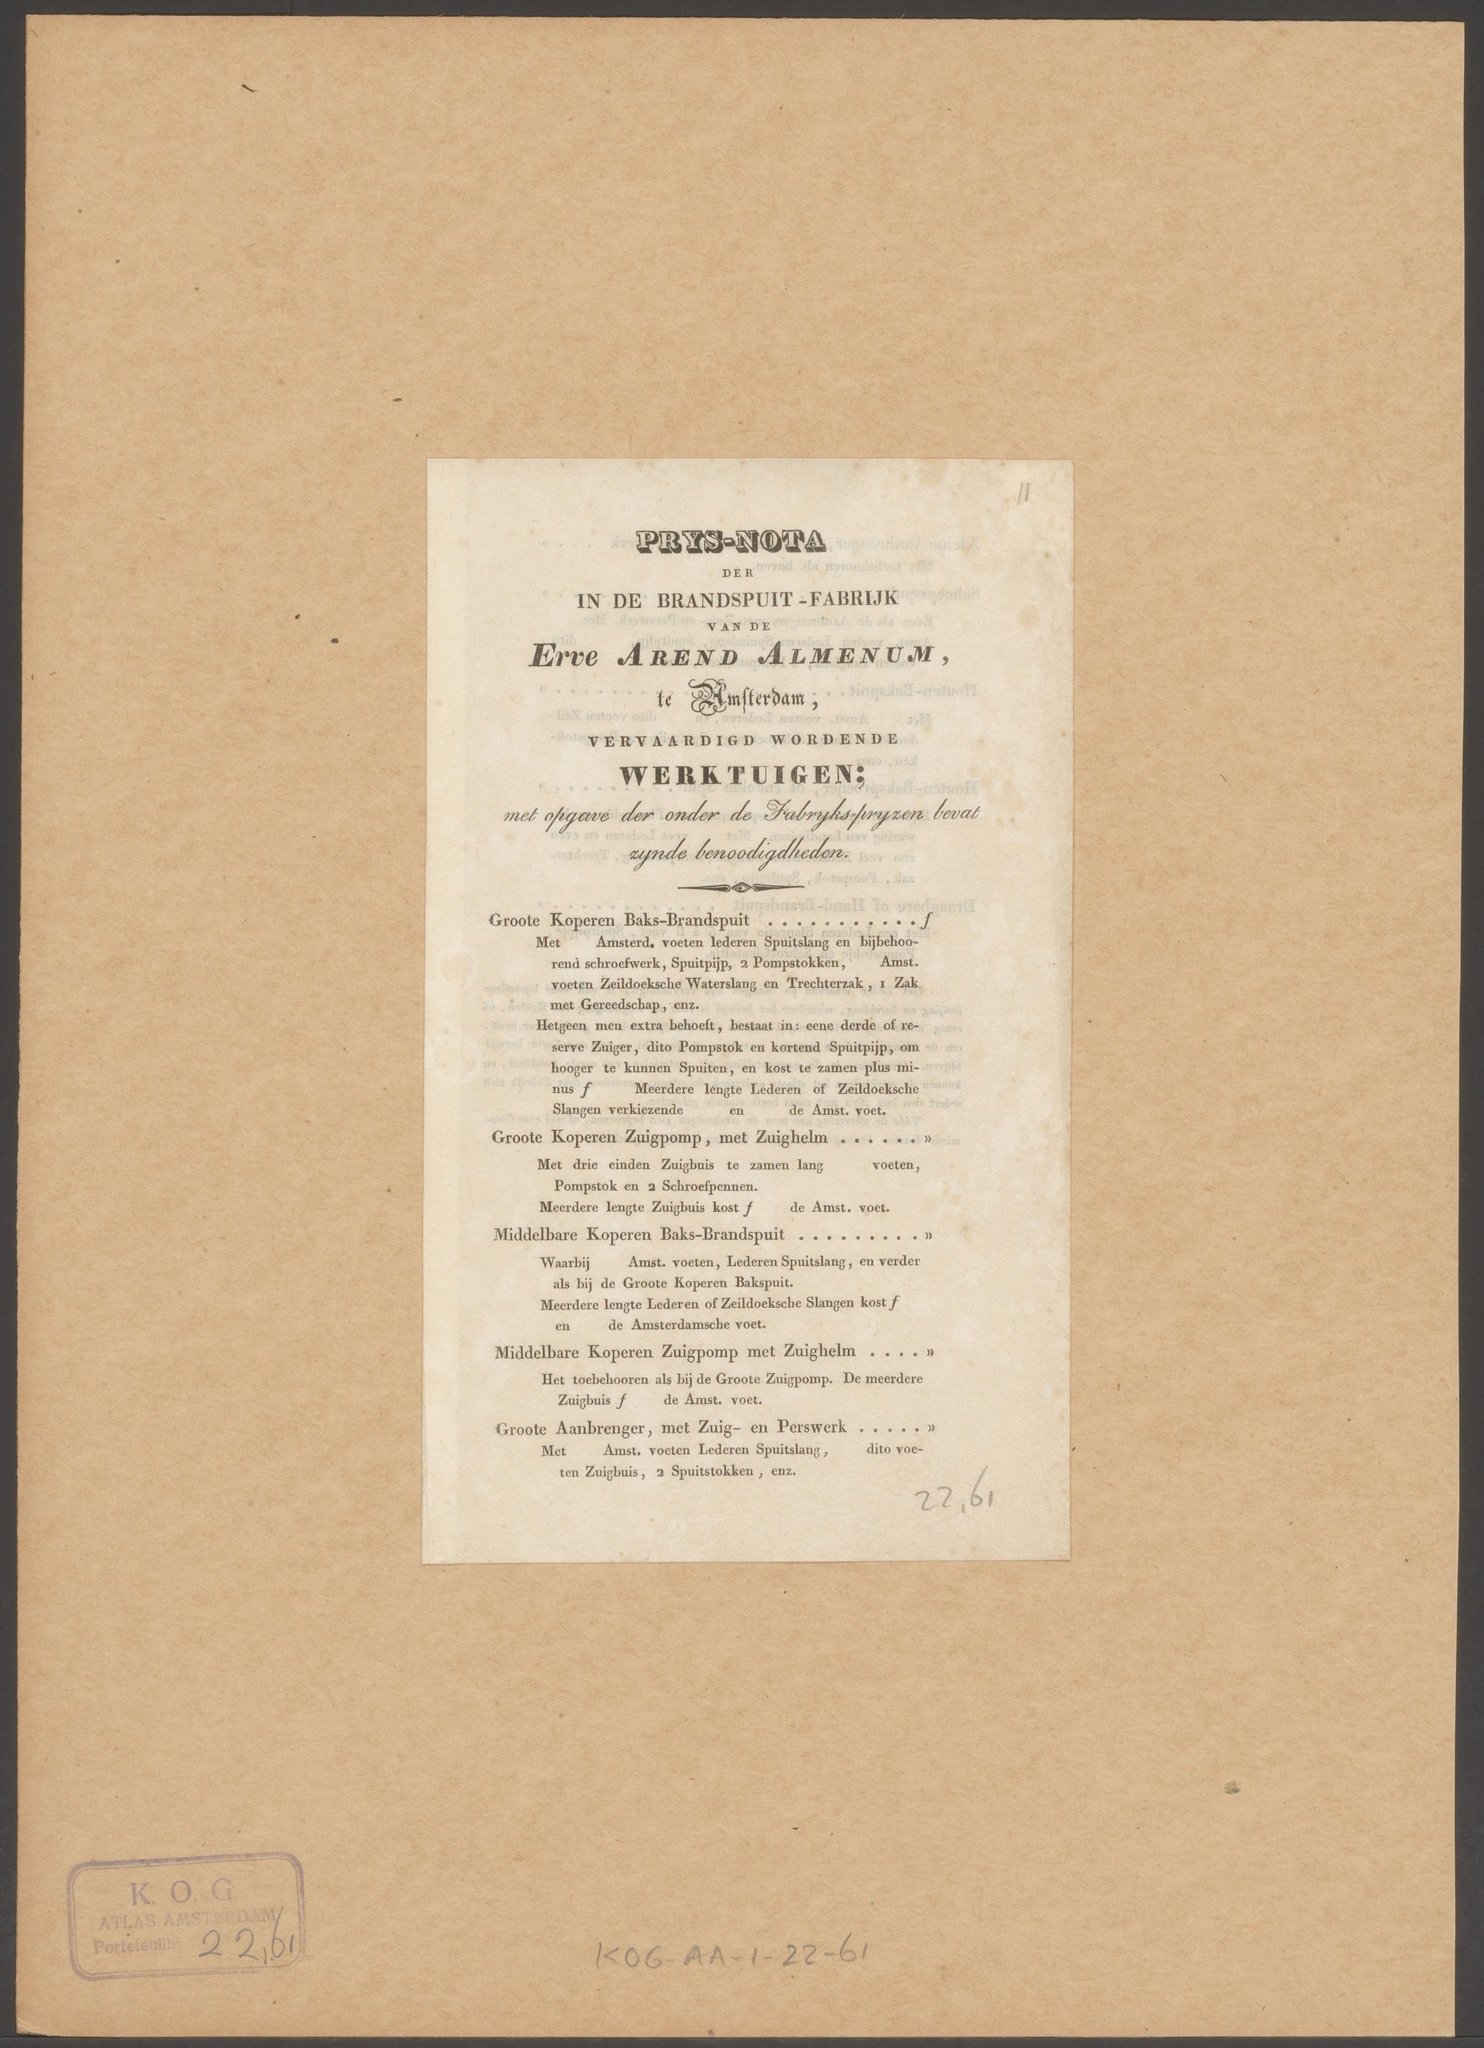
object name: price list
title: Prijslijst van brandweermateriaal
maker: Anonymous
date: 1784-1850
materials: paper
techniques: letterpress printing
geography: netherlands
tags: fire-extinguishing equipment, amsterdam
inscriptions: collector's mark: Lugt 1641b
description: Prijzen zijn niet ingevuld. Onderwerpsrubriek binnen de Atlas Amsterdam: Gemeentewerken: A. Brandweer.